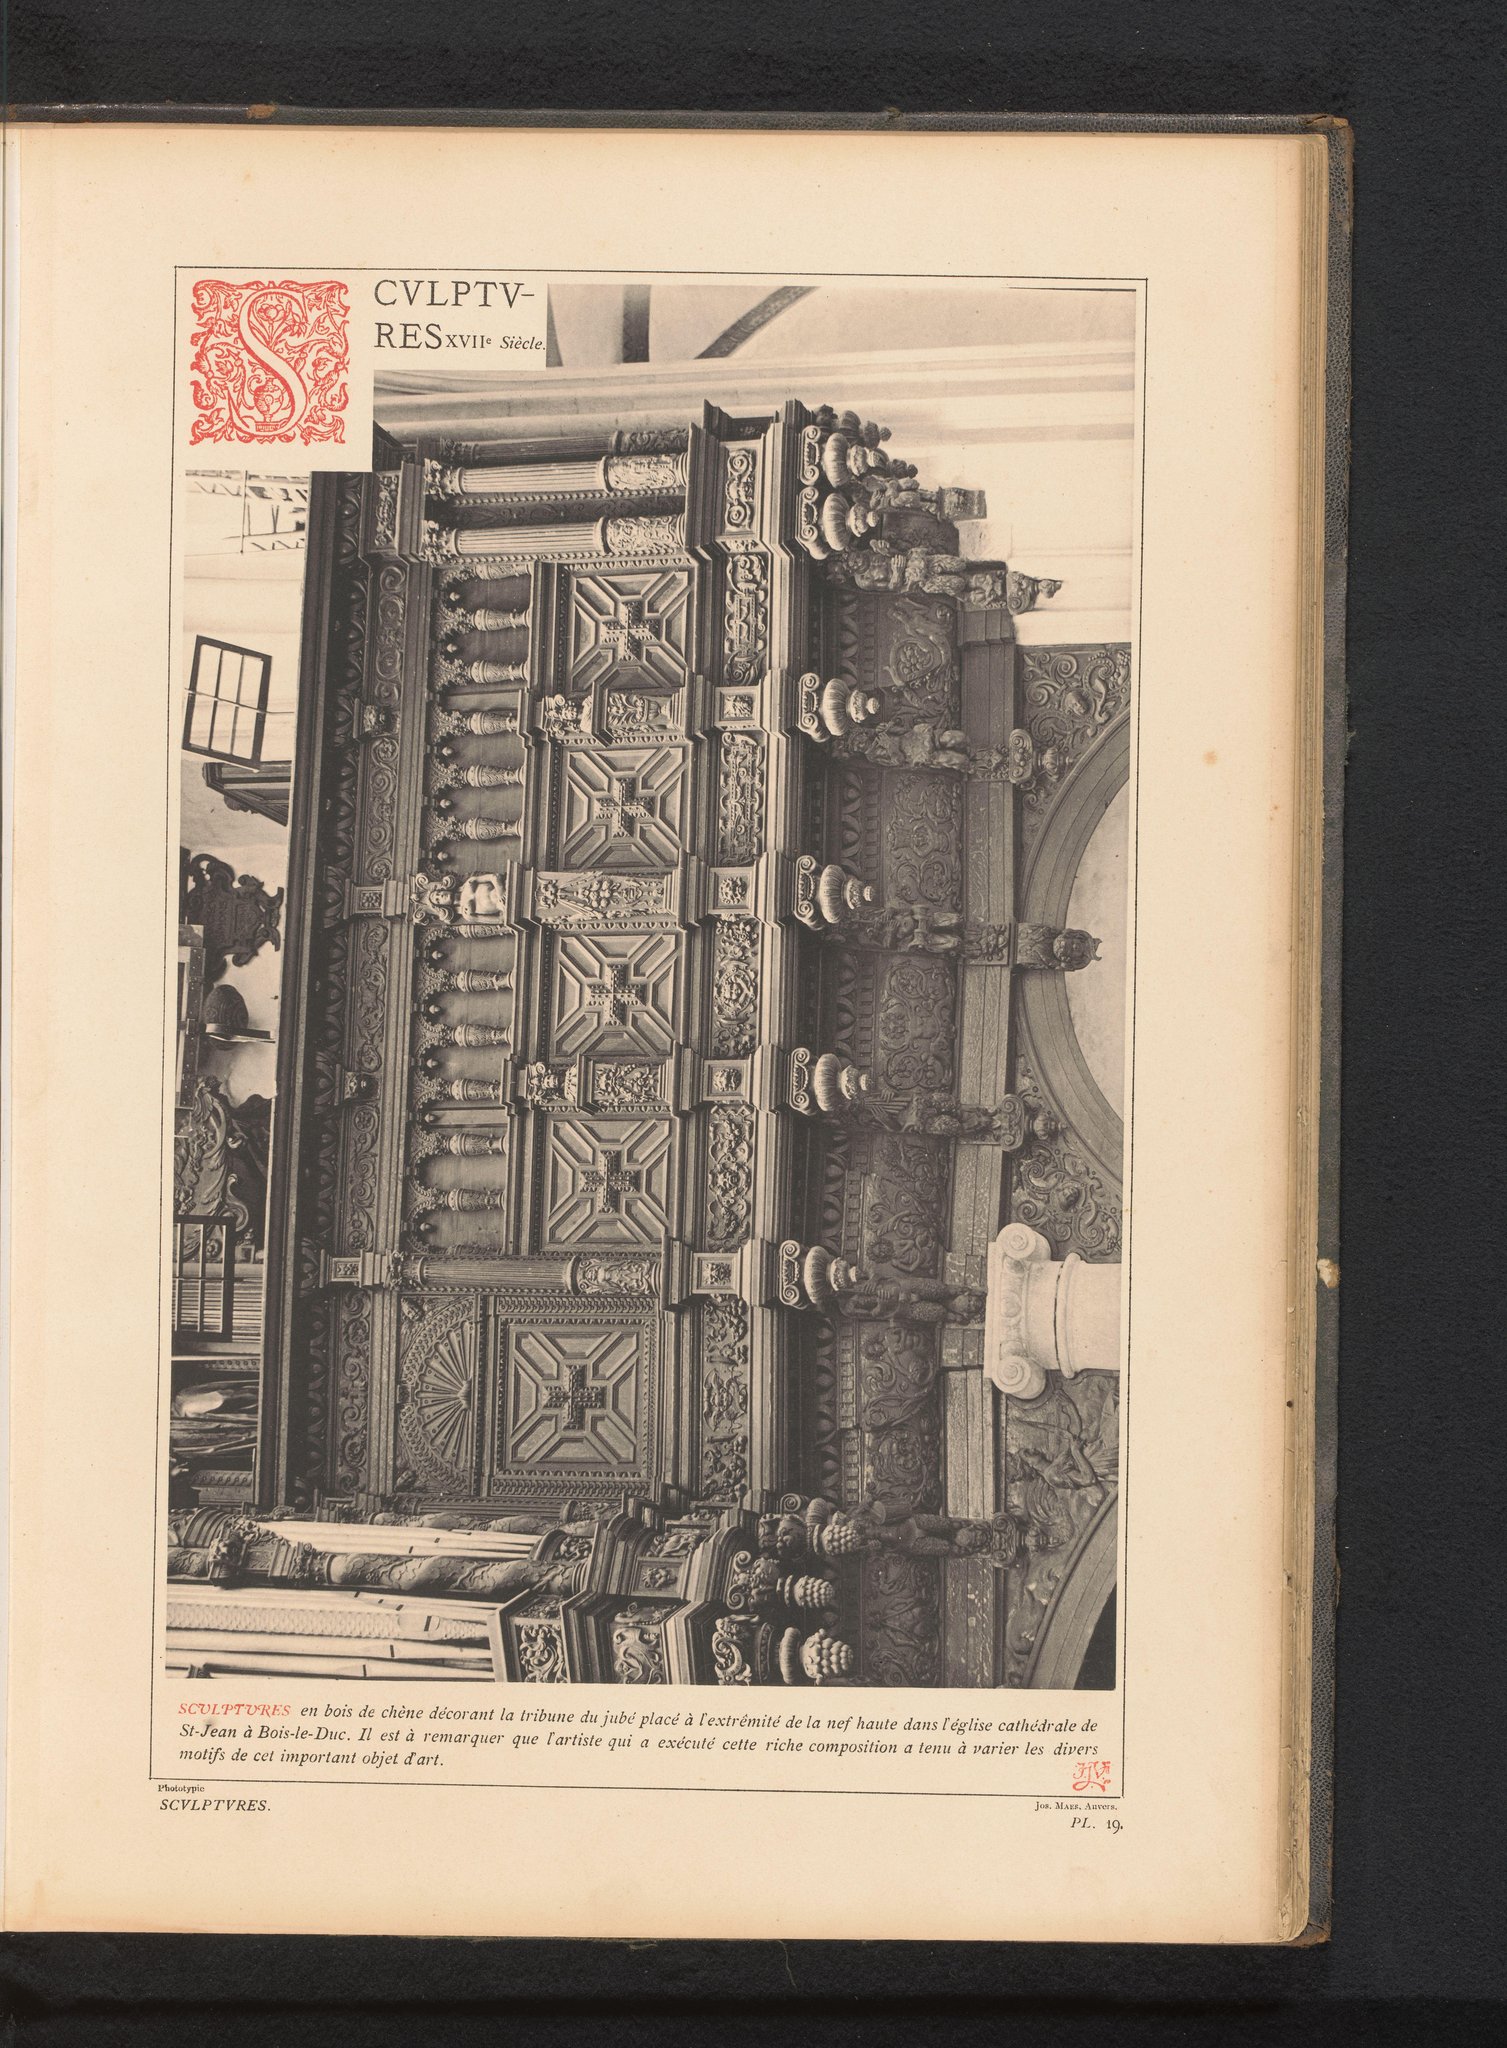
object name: page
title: Houten jubee in de Sint-Janskathedraal te Den Bosch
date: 1881-1889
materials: paper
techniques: photograph, photolithography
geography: den bosch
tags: rood-screen, choir-screen; iconostasis, sculpture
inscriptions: inscription: ‘SCULPTURES en bois (...)’, inscription: ‘SCULPTURES. PL. 19.’, monogram: ‘JJvY’